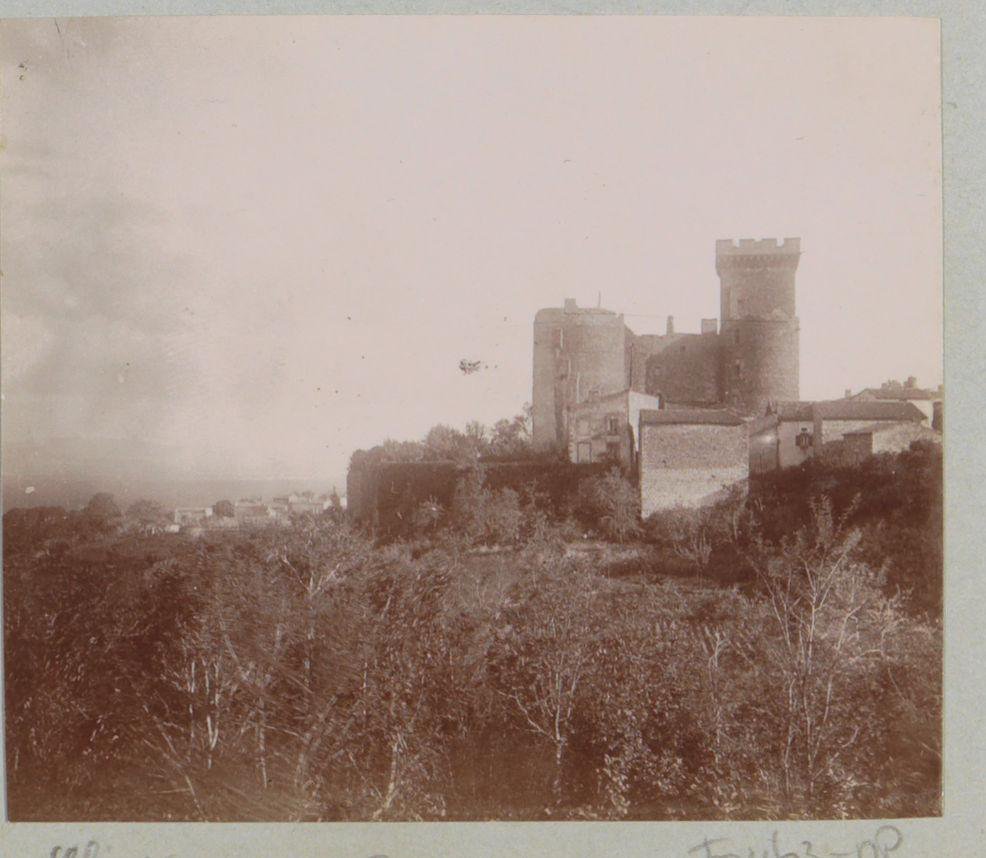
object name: photograph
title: Gezicht op het Kasteel van Châteaugay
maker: delizy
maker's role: manufacturer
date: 1902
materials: paper, photographic support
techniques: gelatin silver print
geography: châteaugay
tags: church (exterior)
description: Onderdeel van Fotoalbum van een Franse amateurfotograaf met opnames van uitstapjes in Frankrijk, Spanje, België, Luxemburg en Nederland, de eerste automobielen en autoraces.